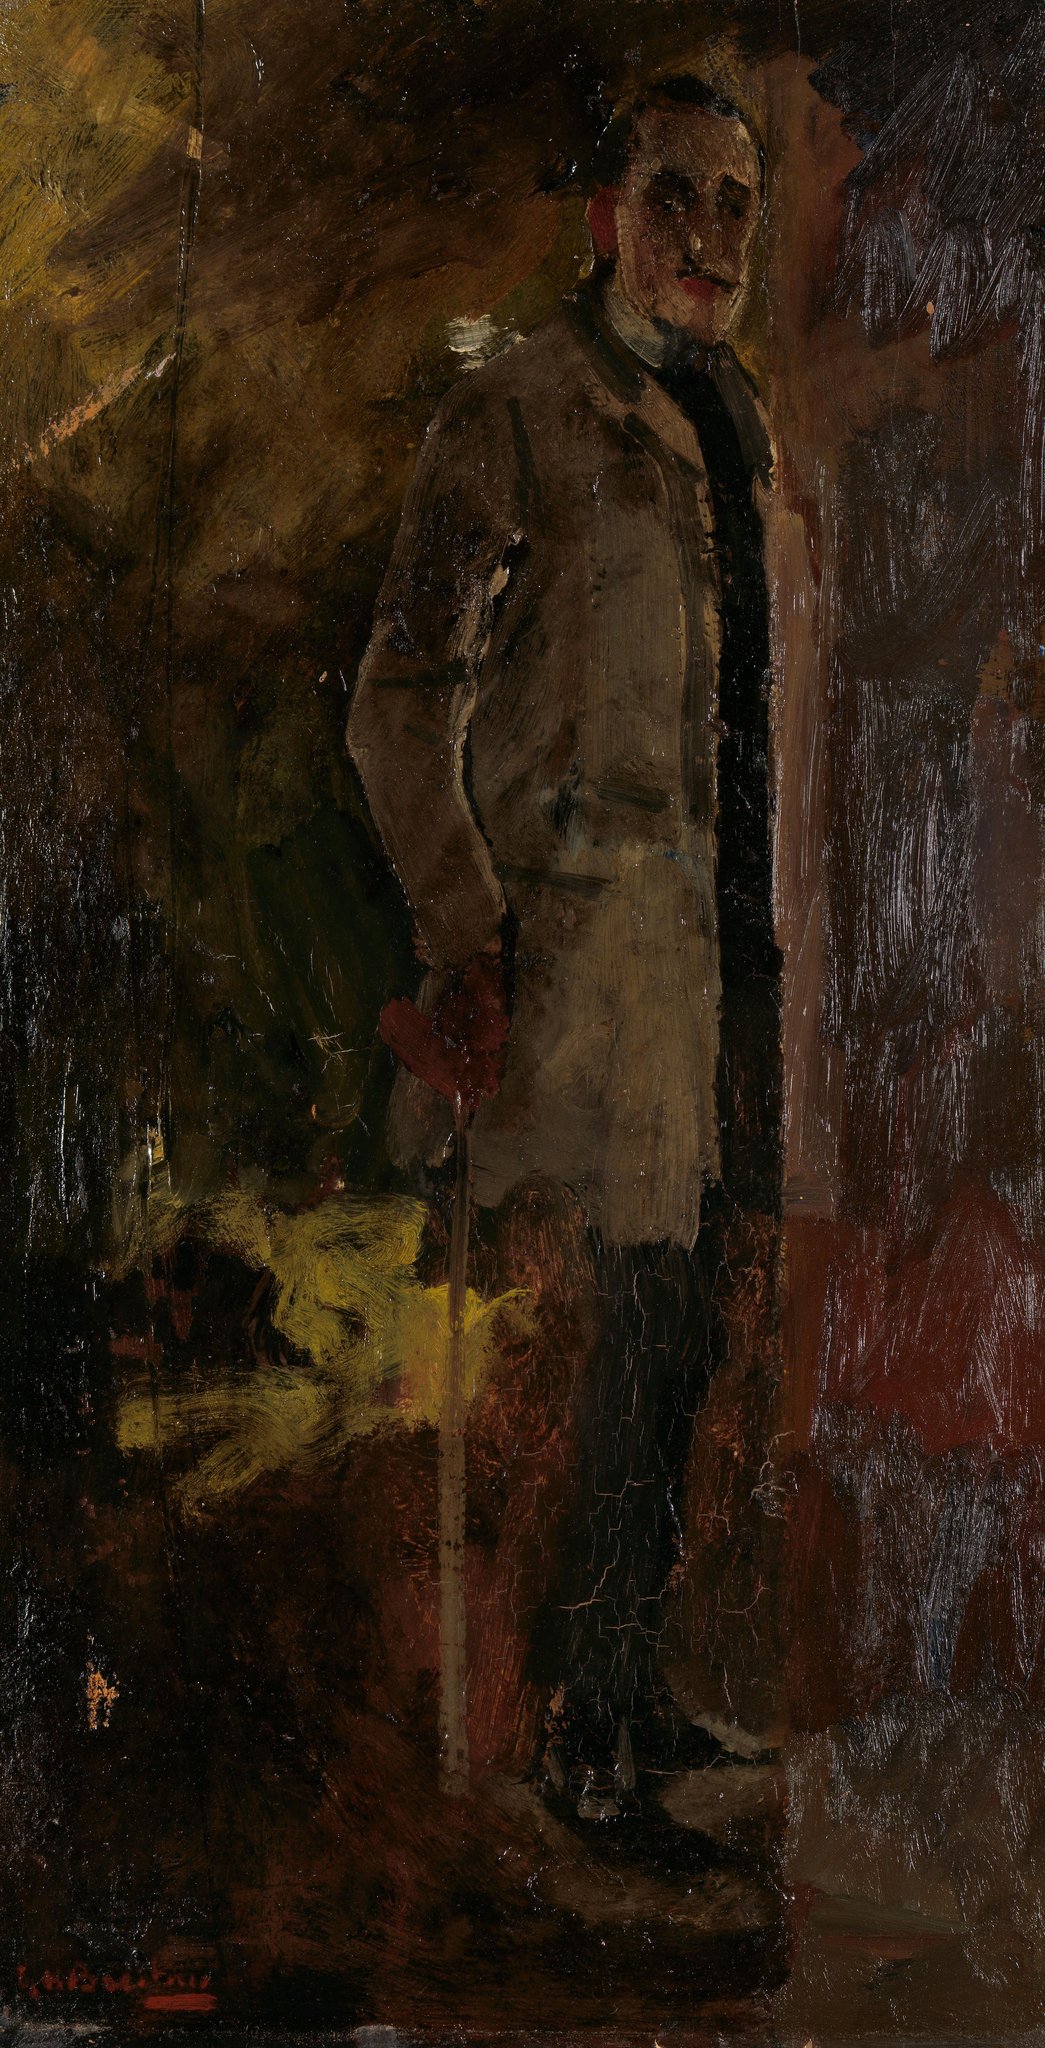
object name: painting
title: Dr van Hoorn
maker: george hendrik breitner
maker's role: draughtsman, painter, print maker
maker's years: 1857-1923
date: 1880-1923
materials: oil, panel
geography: netherlands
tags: leiden, painter, print maker, draughtsman, floris verster, historical persons, portrait, self-portrait of artist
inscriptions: signature: ‘G.H. Breitner’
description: Portret van de schilder Floris Verster. Staande, ten voeten uit, een wandelstok in de rechterhand. Vroeger beschouwd als een portret van Dr. van Hoorn.